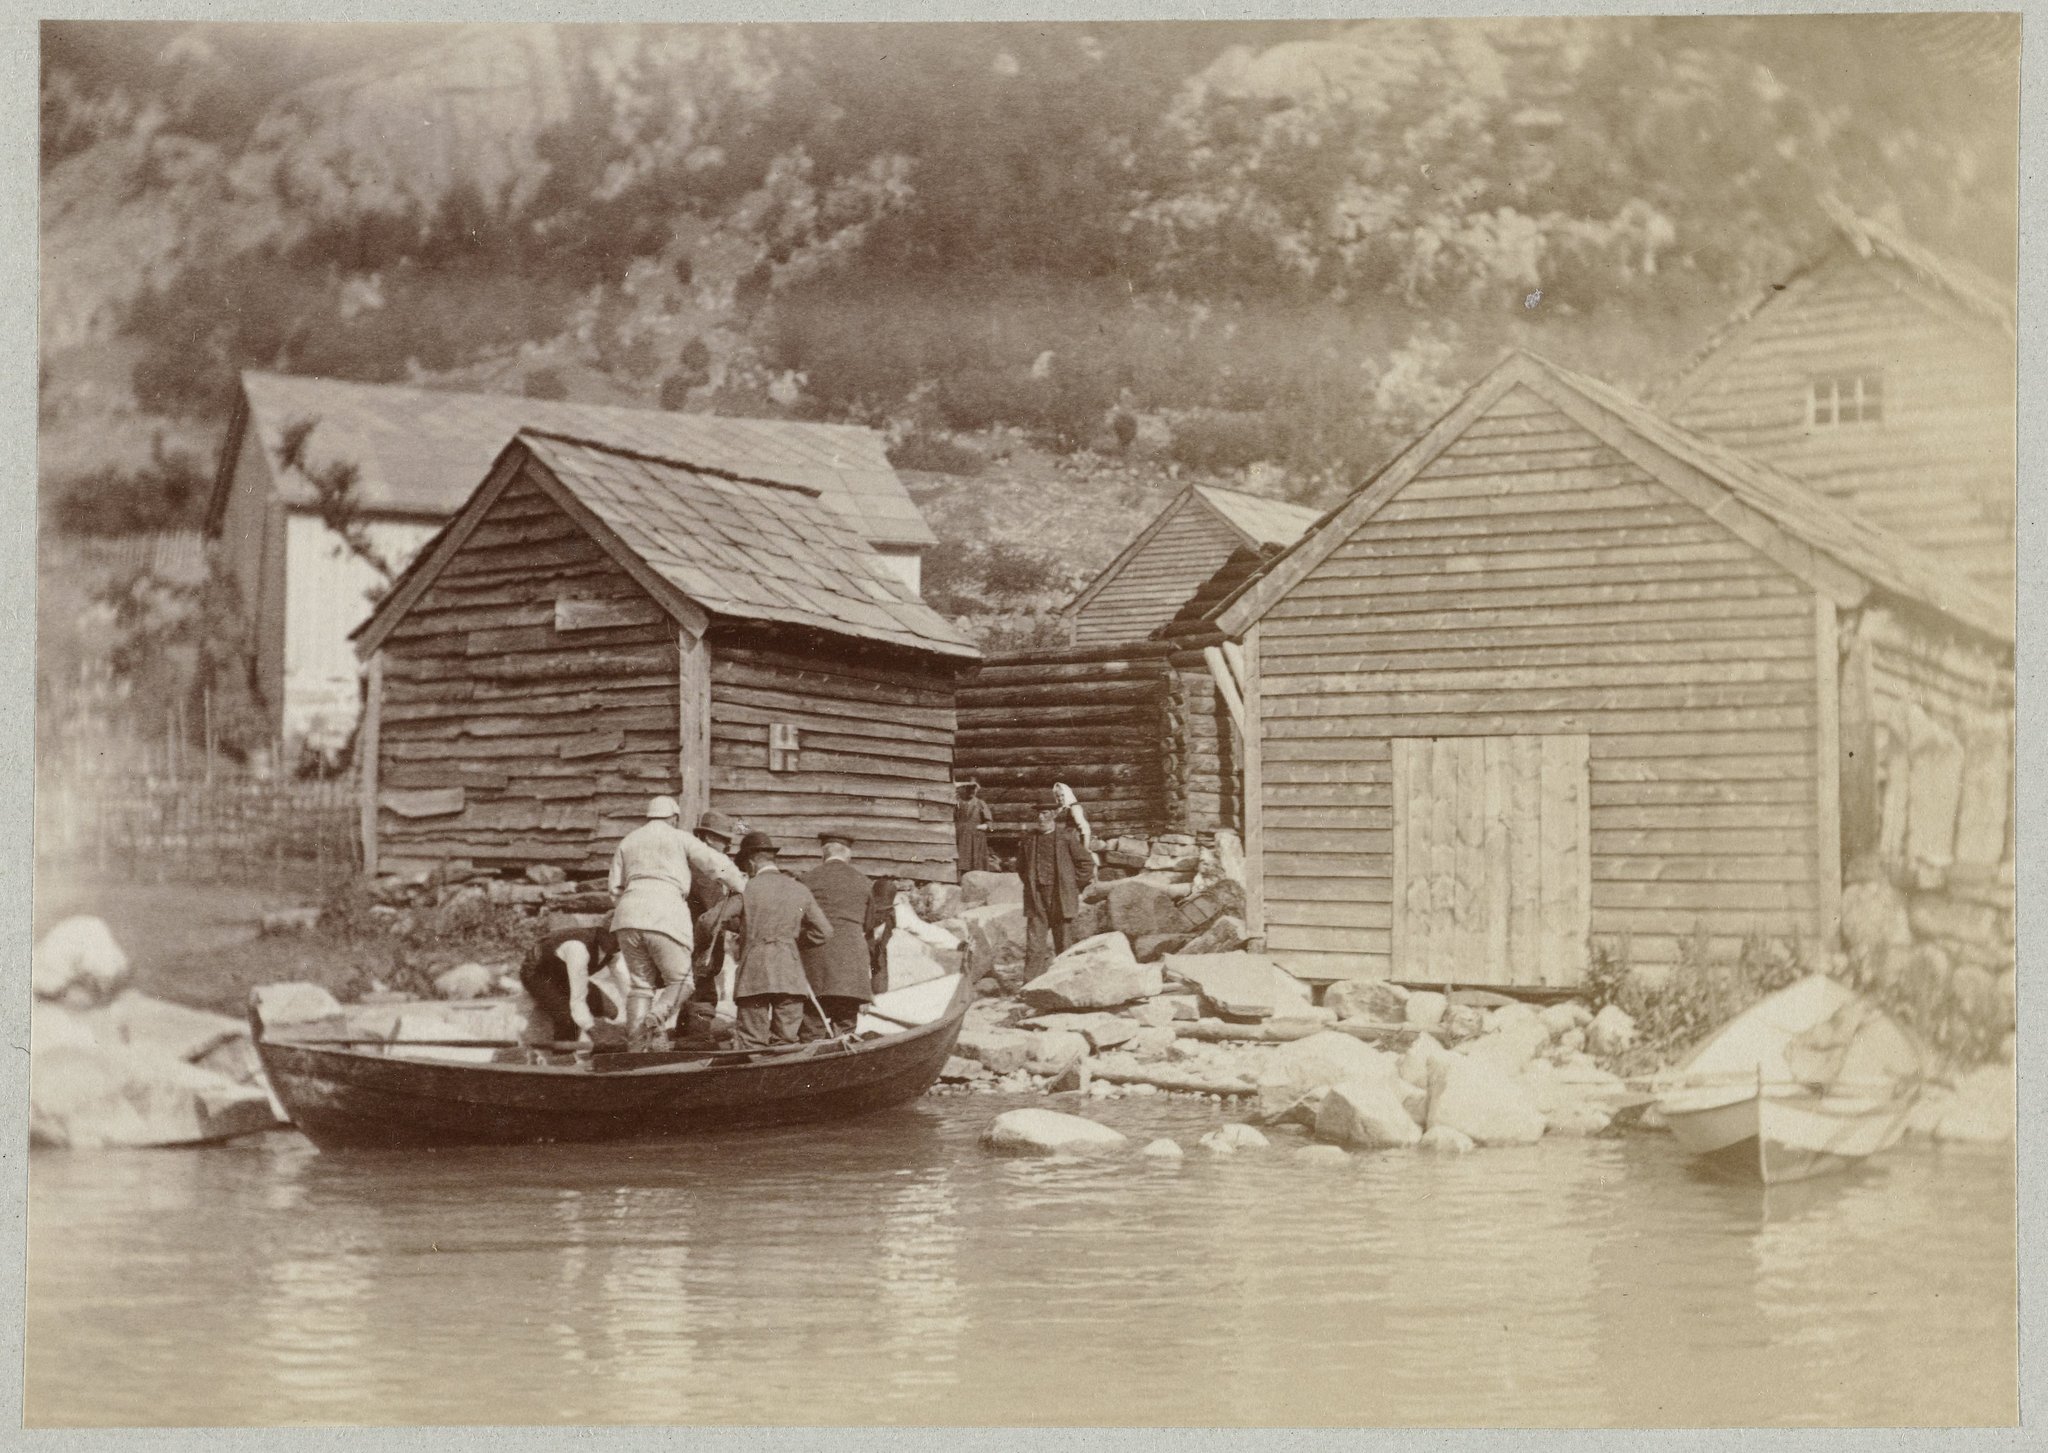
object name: photograph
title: Roeiboot met passagiers meert aan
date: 1807-1889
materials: cardboard, paper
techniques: albumen print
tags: wilhelm ii (keizer van duitsland), norway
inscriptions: number: ‘6’